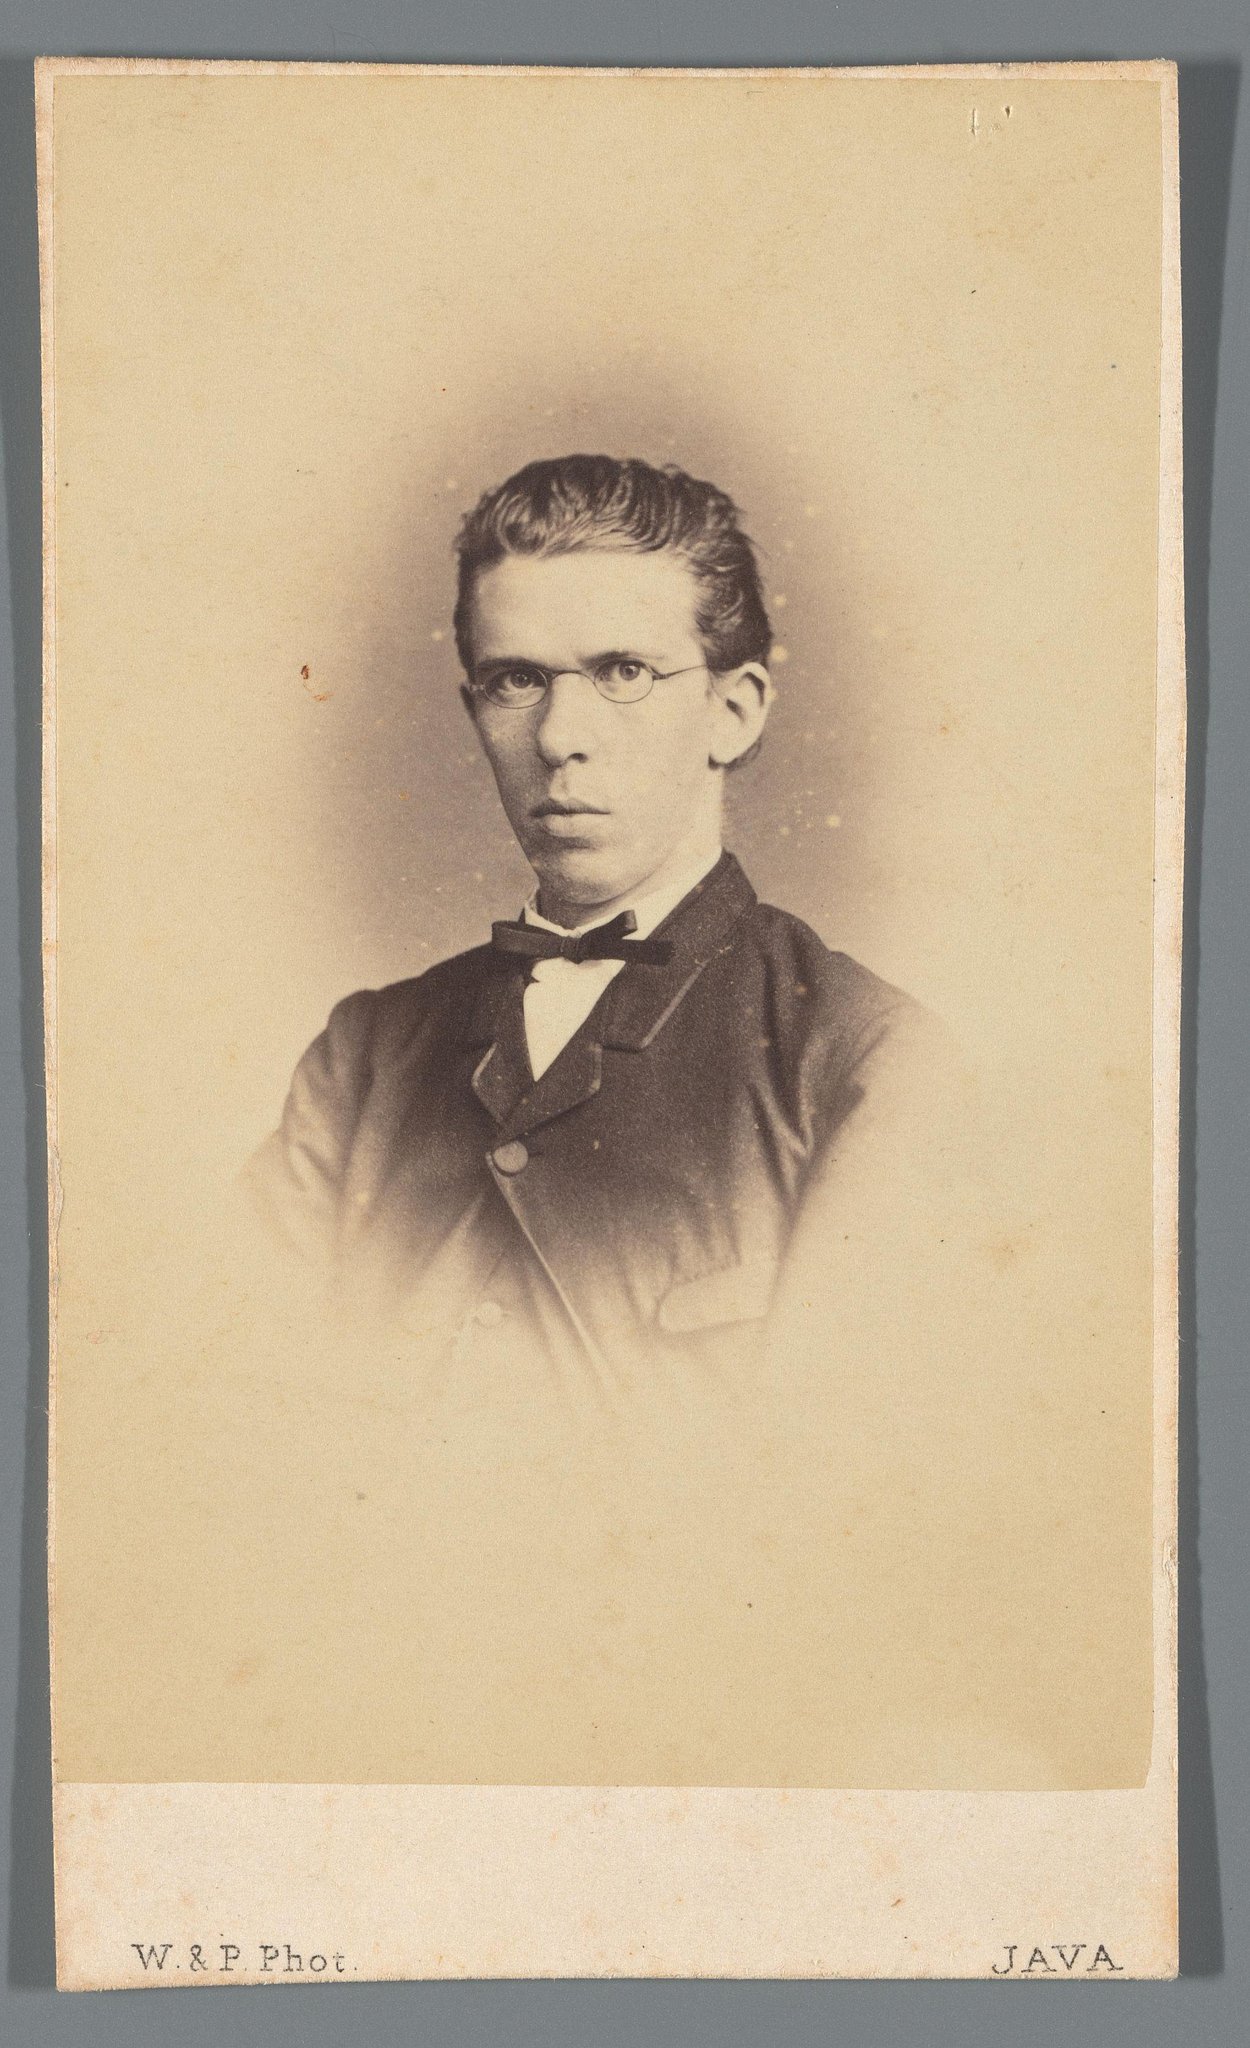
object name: photograph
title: Portret van Henricus Petrus Joannes van den Berg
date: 1860-1880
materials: cardboard, photographic support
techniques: albumen print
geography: java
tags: henricus petrus joannes van den berg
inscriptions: name: ‘W.&P. Phot. JAVA’, name: ‘WOODBURY & PAGE , / PHOTOGRAPHERS / JAVA .’, inscription: ‘vader H.P.J.v.d. Berg’